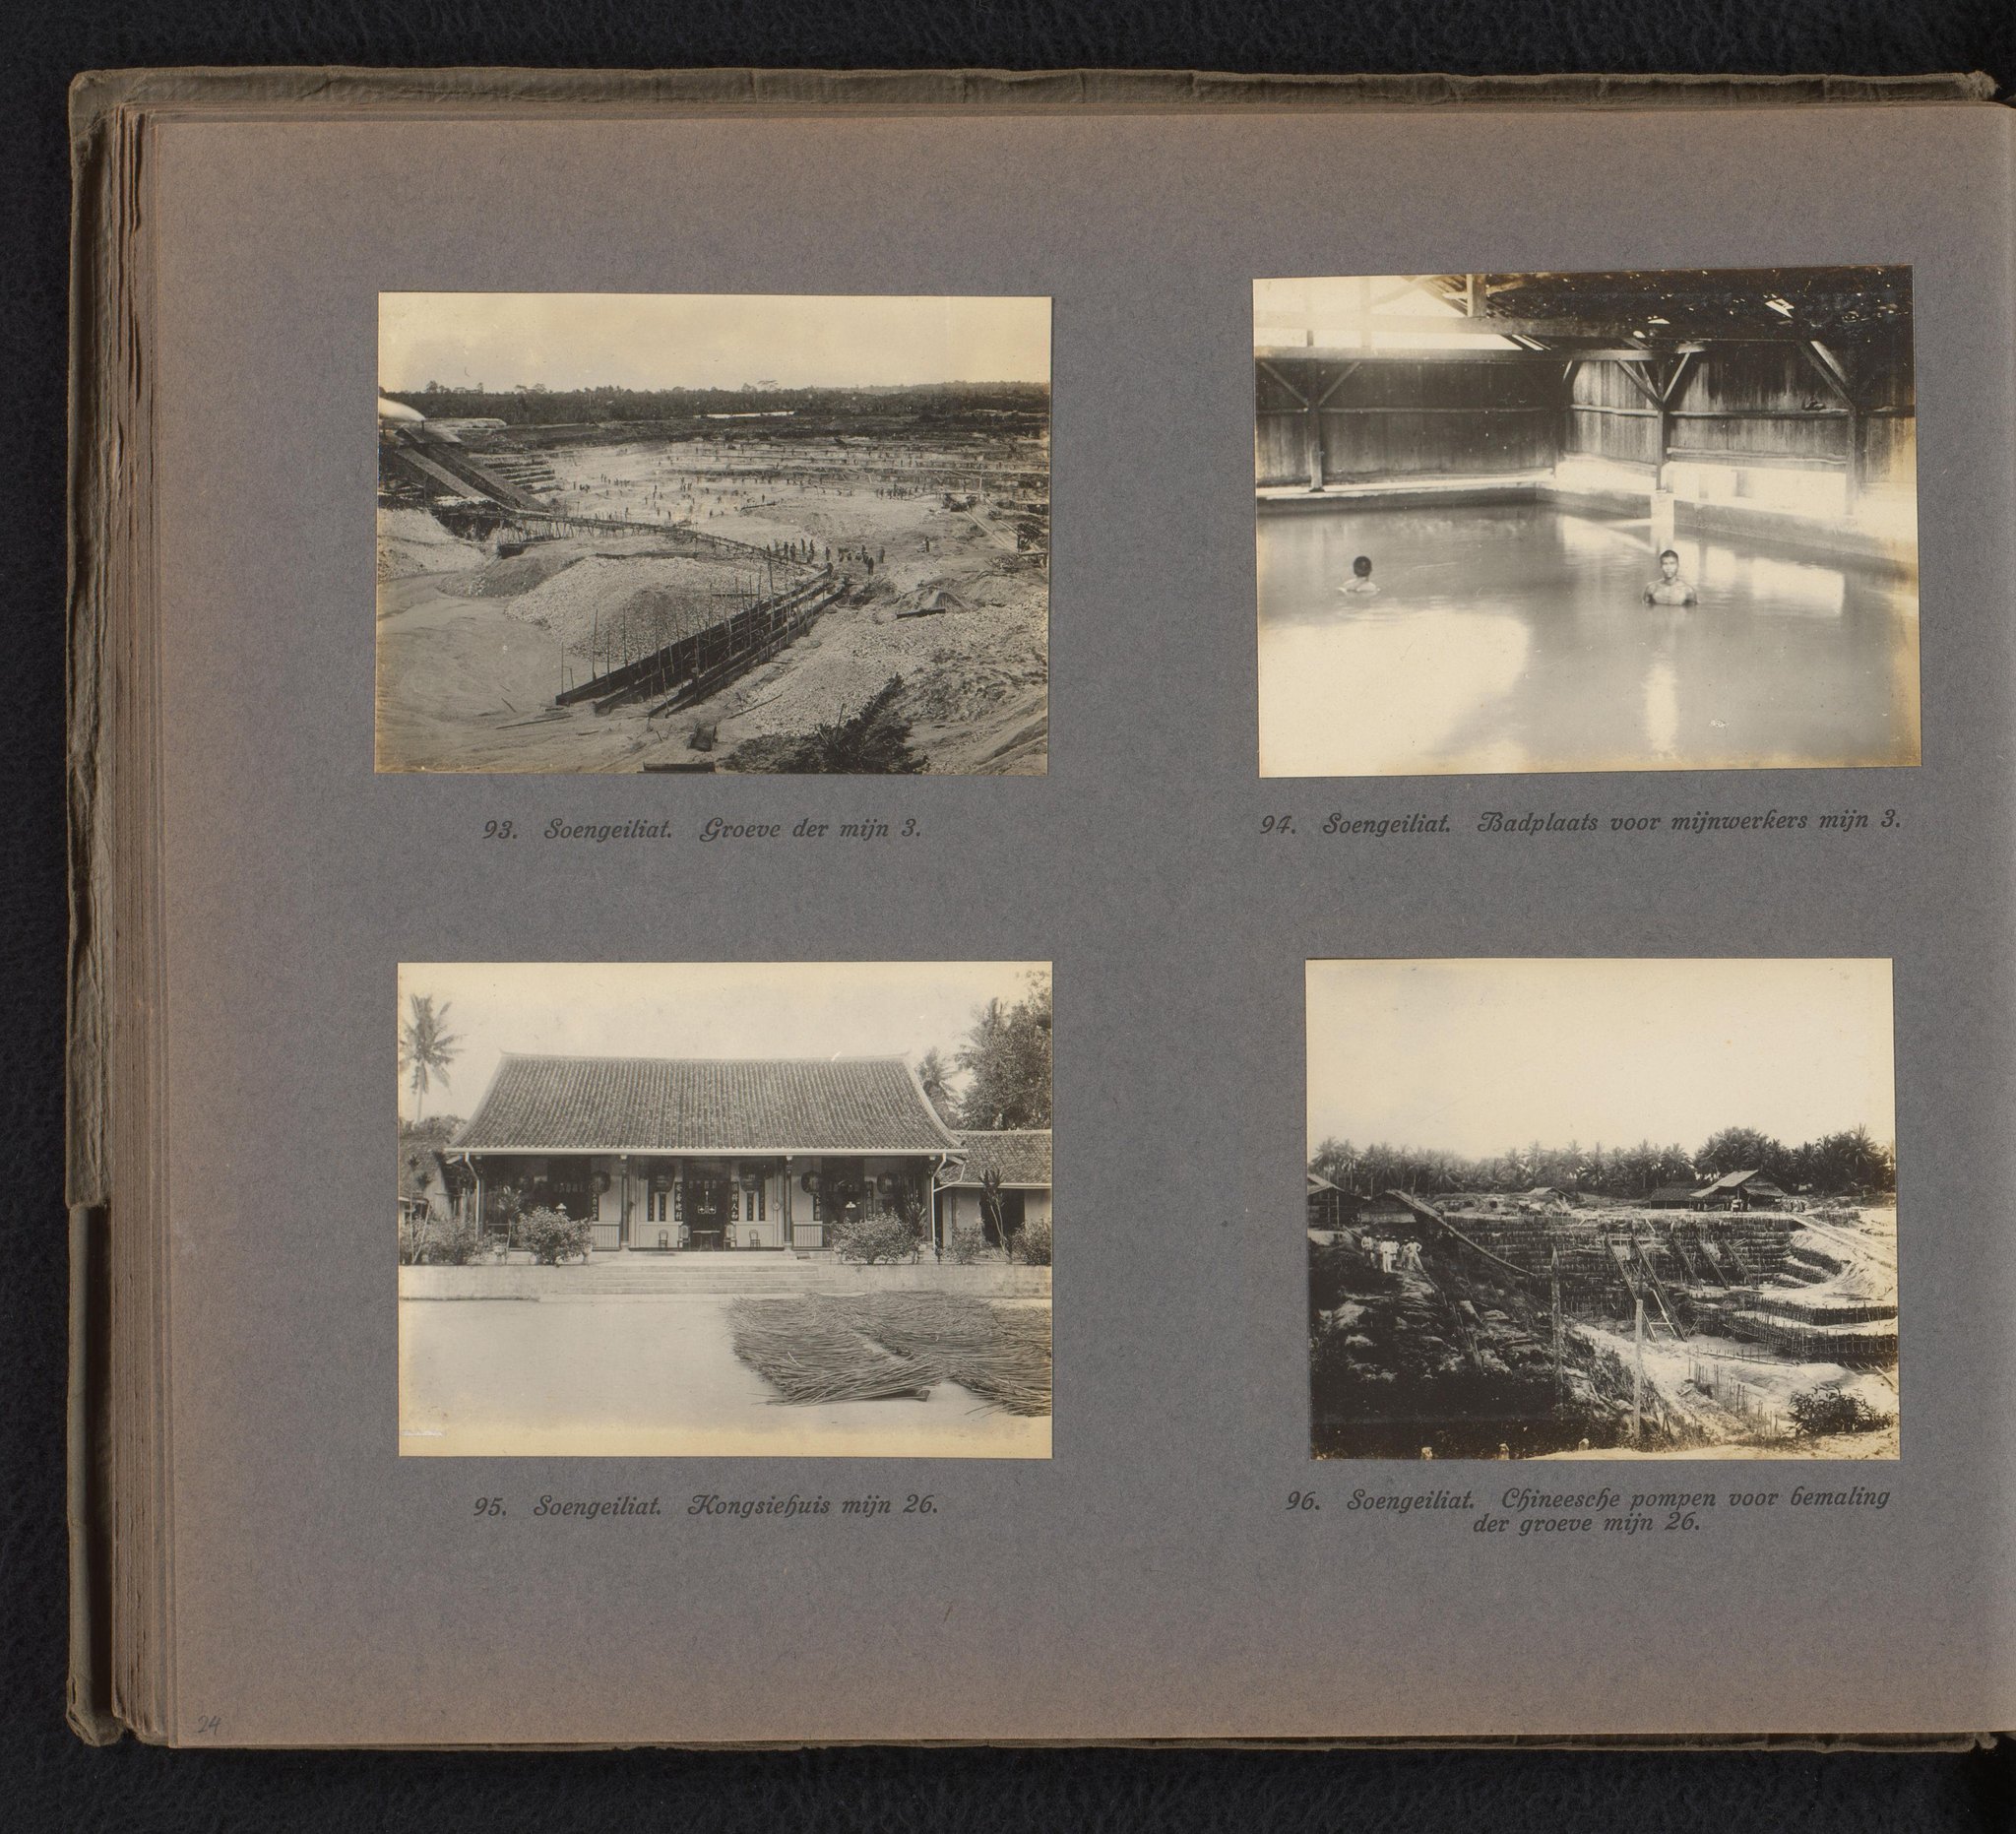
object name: photograph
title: Gezichten te Soengeiliat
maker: Anonymous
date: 1907-1919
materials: cardboard, photographic support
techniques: gelatin silver print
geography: bangka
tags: robert julius boers, colonial system, opencast mine; strip mining, minerals and metals: tin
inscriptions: inscription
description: Albumblad met vier foto's genummerd 93-96 van verschillende gezichten bij de tinmijnen te Soengeiliat op Banka: groeve, zwembad en Chinees kongsiehuis. Onderdeel van het Banka-Album met foto's over het eiland Banka en de tinwinning door het staatsbedrijf de Banka-tinwinning in de periode ca. 1907-1919.